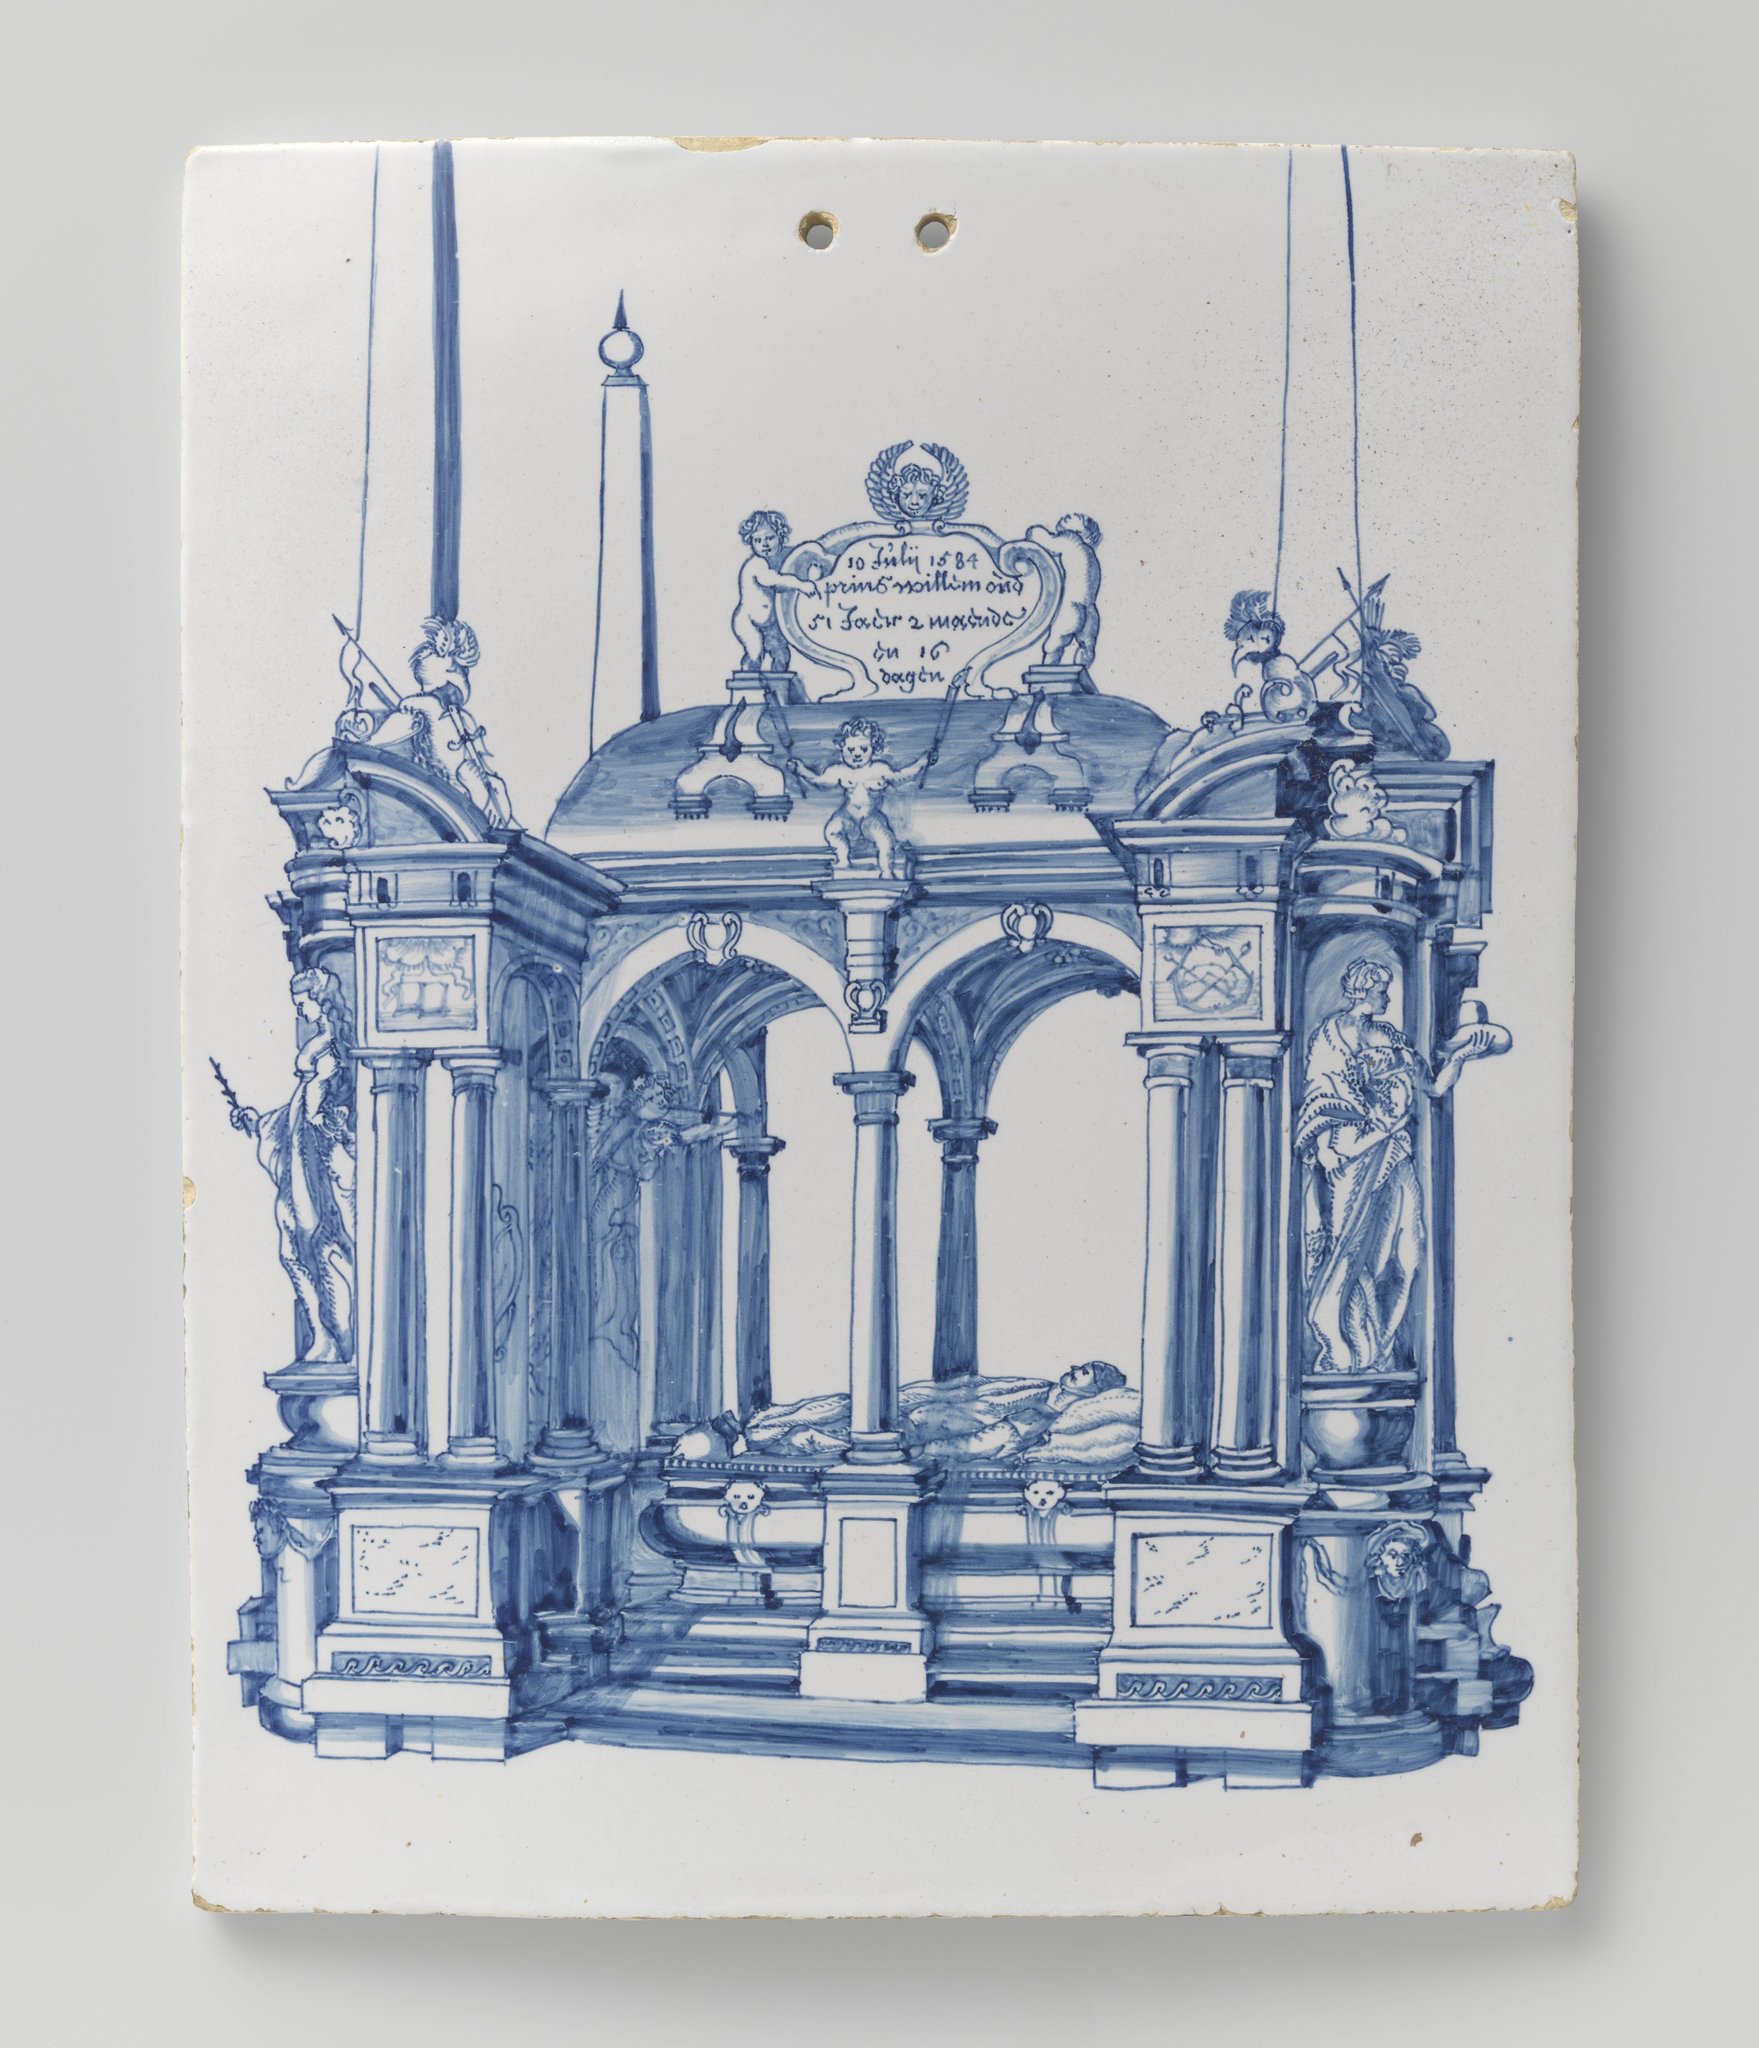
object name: plate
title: Two plaques with the Tomb of William of Orange in the Nieuwe Kerk in Delft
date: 1657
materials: earthenware, glaze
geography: delft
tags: delft, william i (prince of orange), grave, tomb and other grave-forms and grave-markers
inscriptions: inscription: ‘10 Julij 1584 prins willem oud 51 Jaer 2 maende en 16 dagen’, signature and date: ‘Junius .6.16.1657’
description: Plaat van faïence, beschilderd in blauw met een zijaanzicht van het graf van Willem van Oranje (de Zwijger) in de Nieuwe Kerk te Delft.